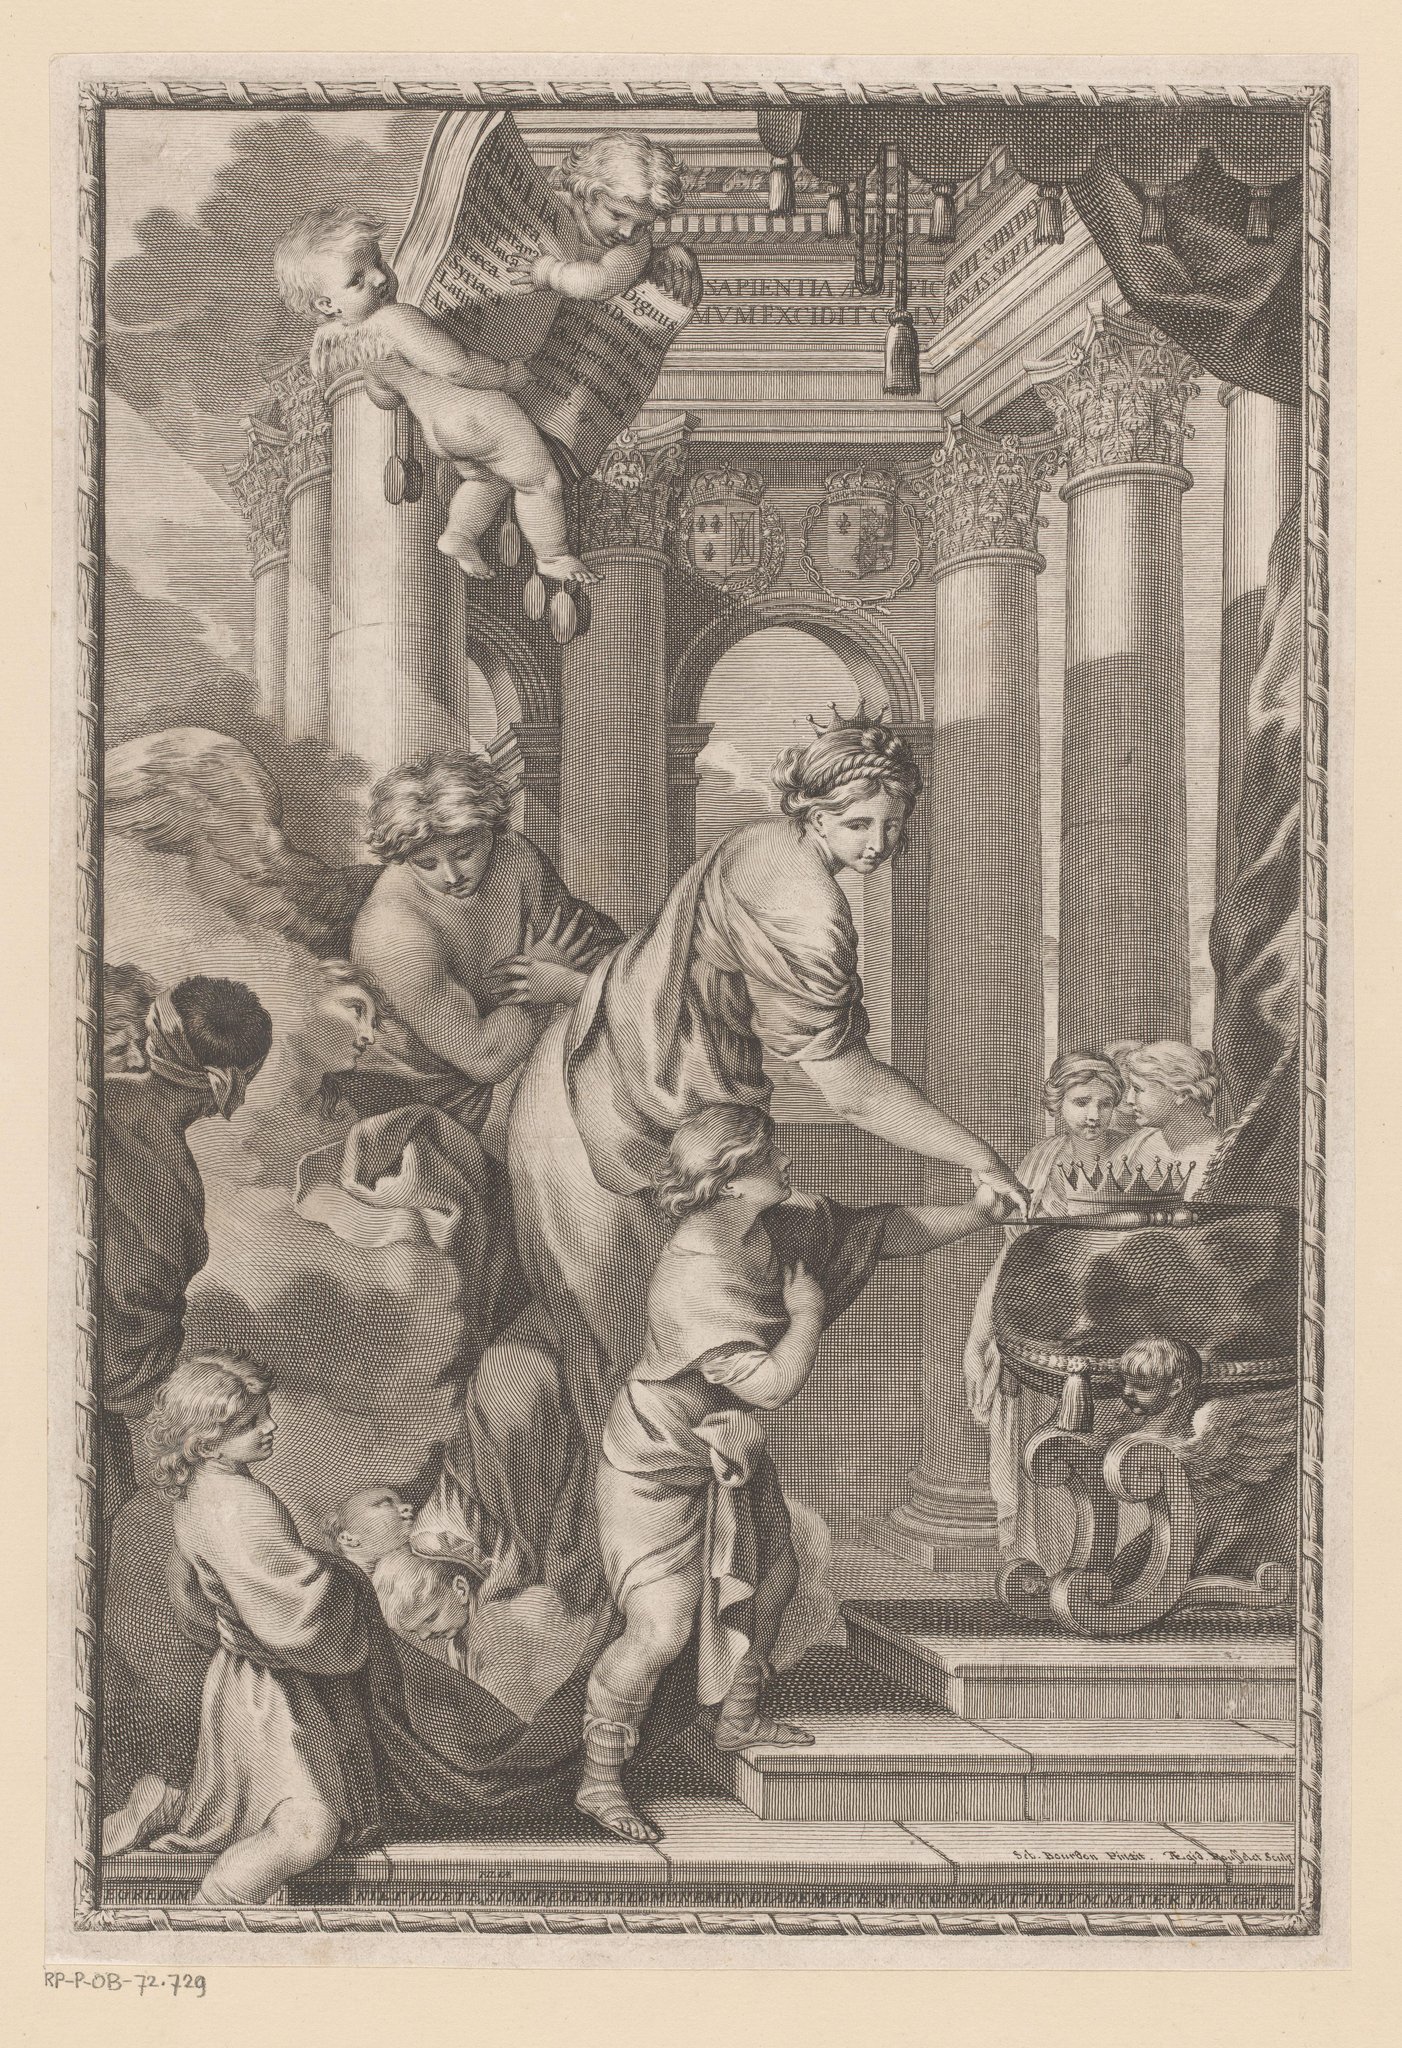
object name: titelblad, titelpagina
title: Batseba leidt haar zoon Salomo naar een troon met daarop een kroon en staf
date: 1645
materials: paper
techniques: engraving, etching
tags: solomon and bathsheba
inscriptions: collector's mark: Lugt 240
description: Titelpagina voor: Le Jay, Guy Michel. Biblia Hebraica, Samaritana, Chaldaica, Graeca, Syriaca, Latina, Arabica. Parijs: Antoine Vitré, 1645.